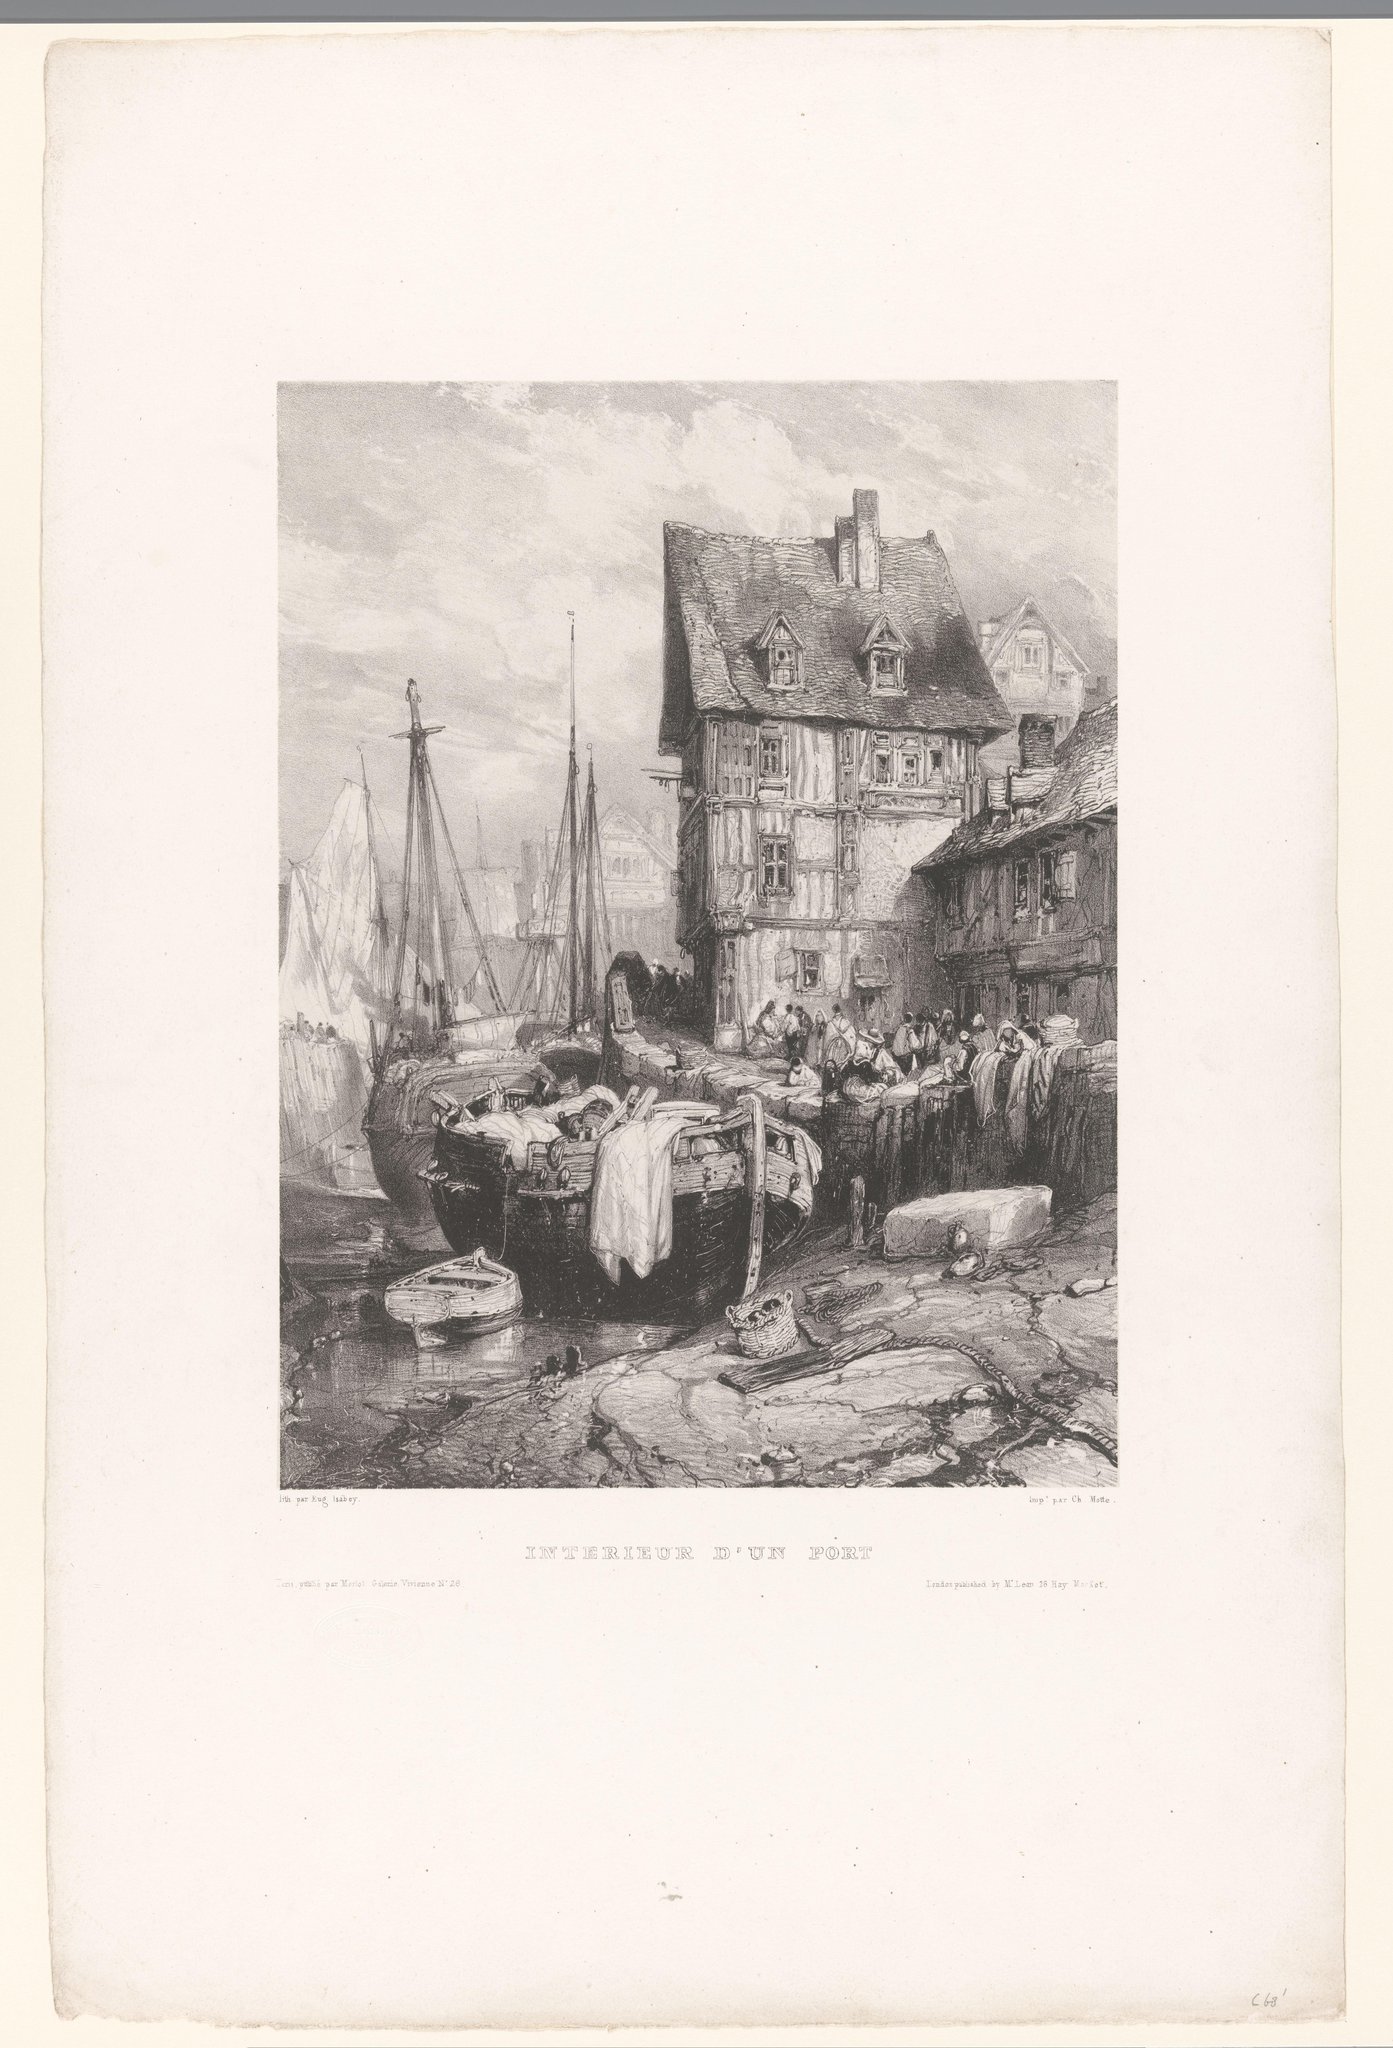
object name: print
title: Six marines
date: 1833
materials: paper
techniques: lithograph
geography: london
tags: ships (in general) - cc - more than one ship, pier, quay, wharf, quay (+ city(-scape) with figures, staffage)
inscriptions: check stamp: Lugt 1826b, collector's mark: Lugt 2228a